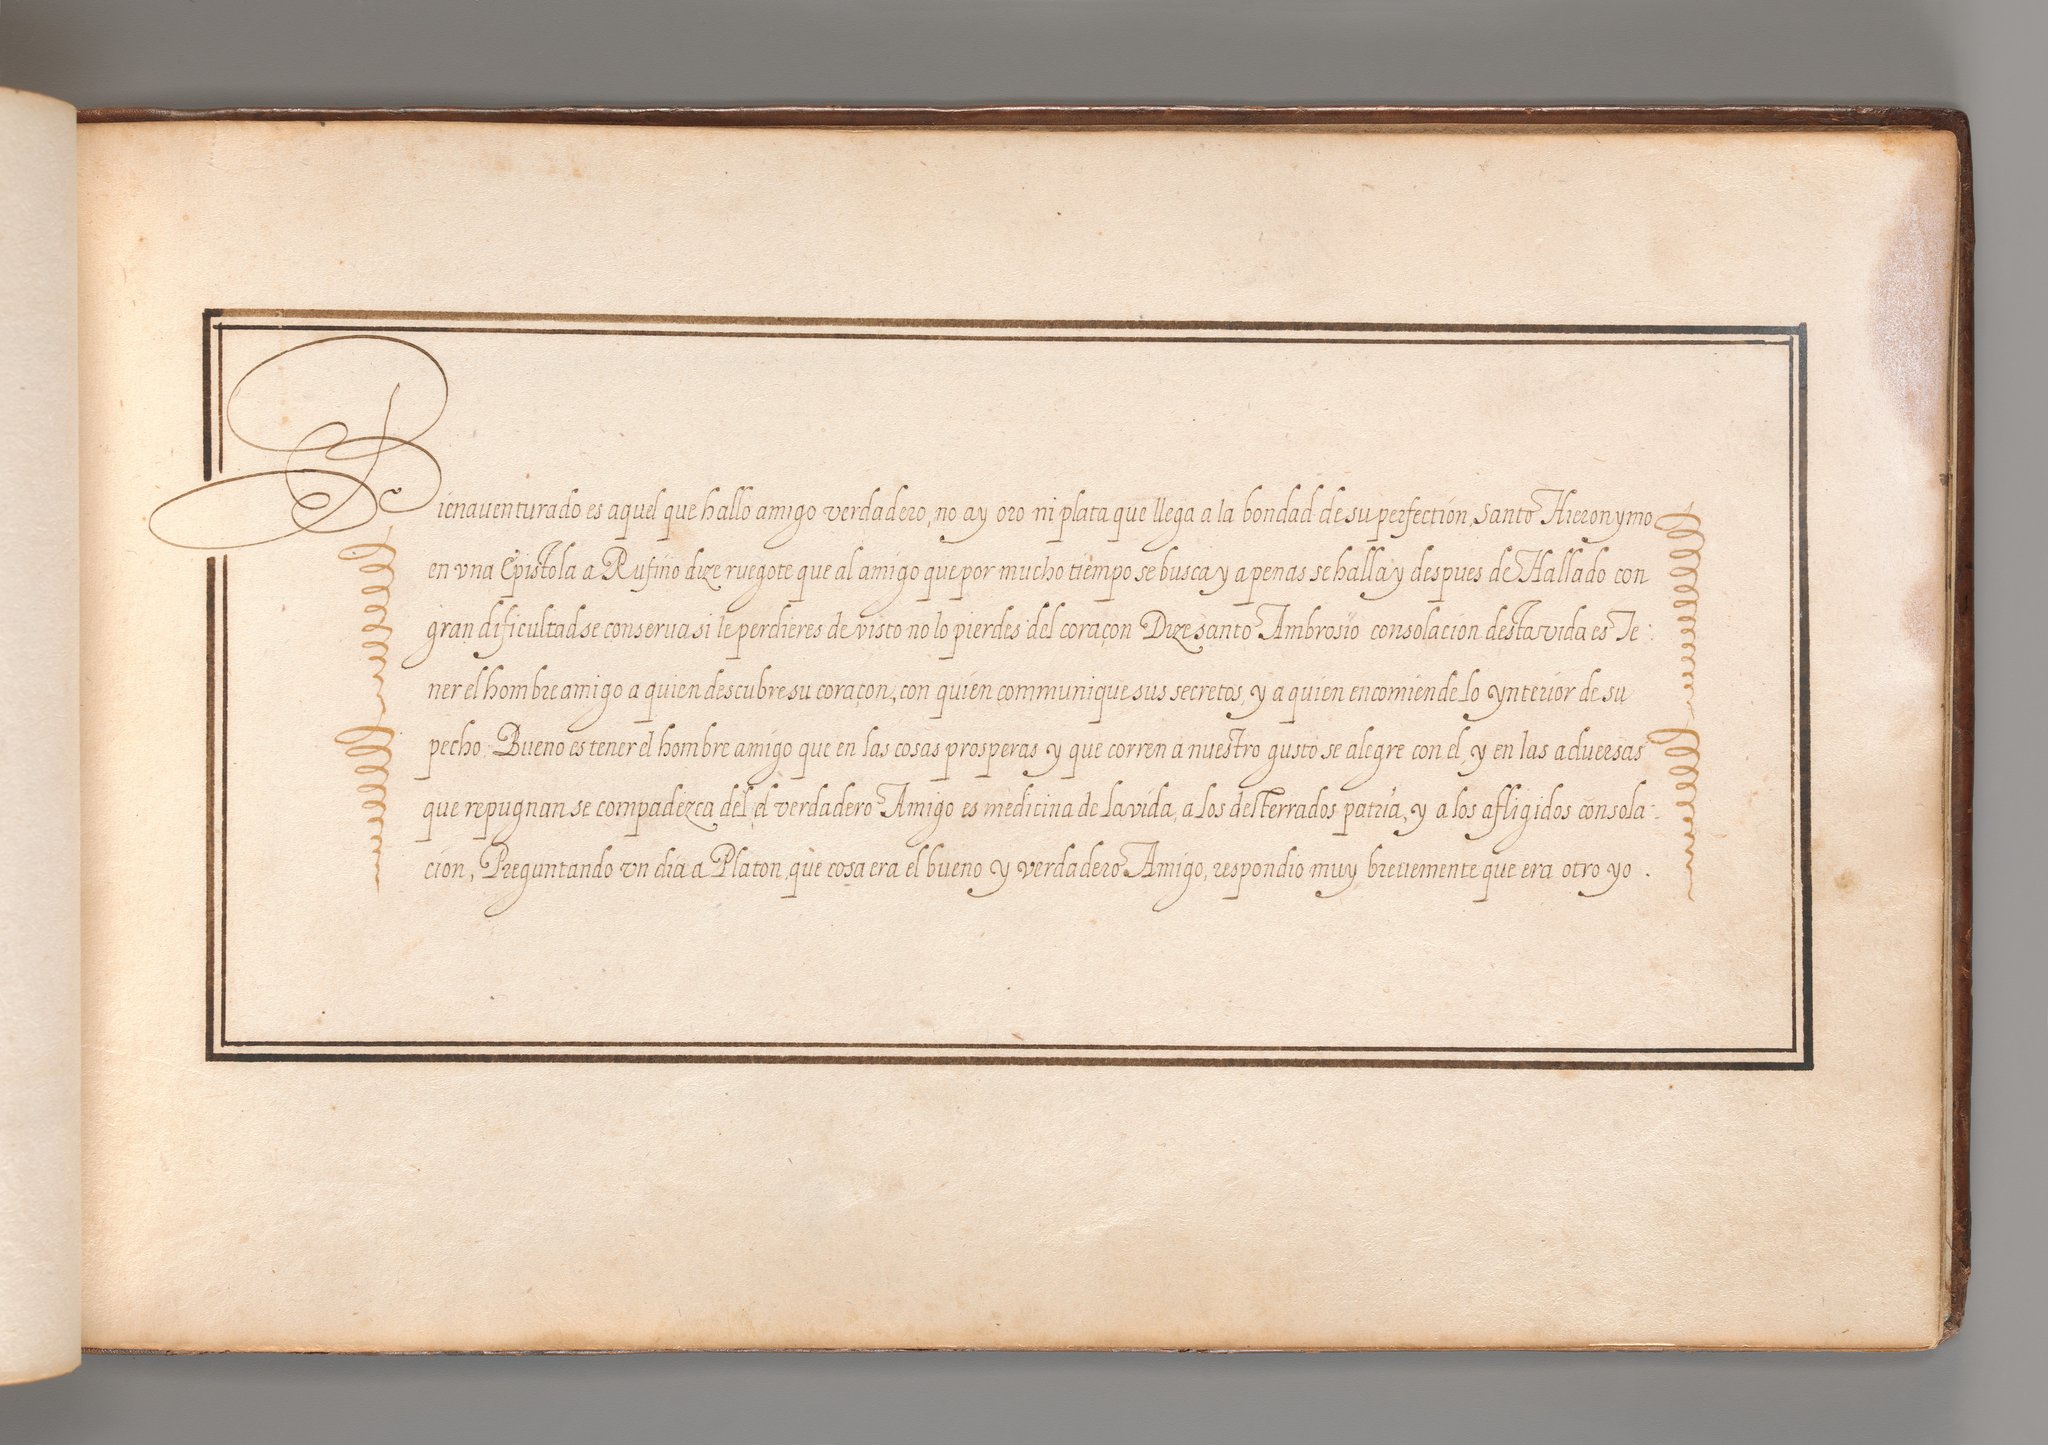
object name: album print ornament architecture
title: Calligraphic Exercise in Spanish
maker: Anonymous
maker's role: artist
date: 1601-1633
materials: ink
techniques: pen